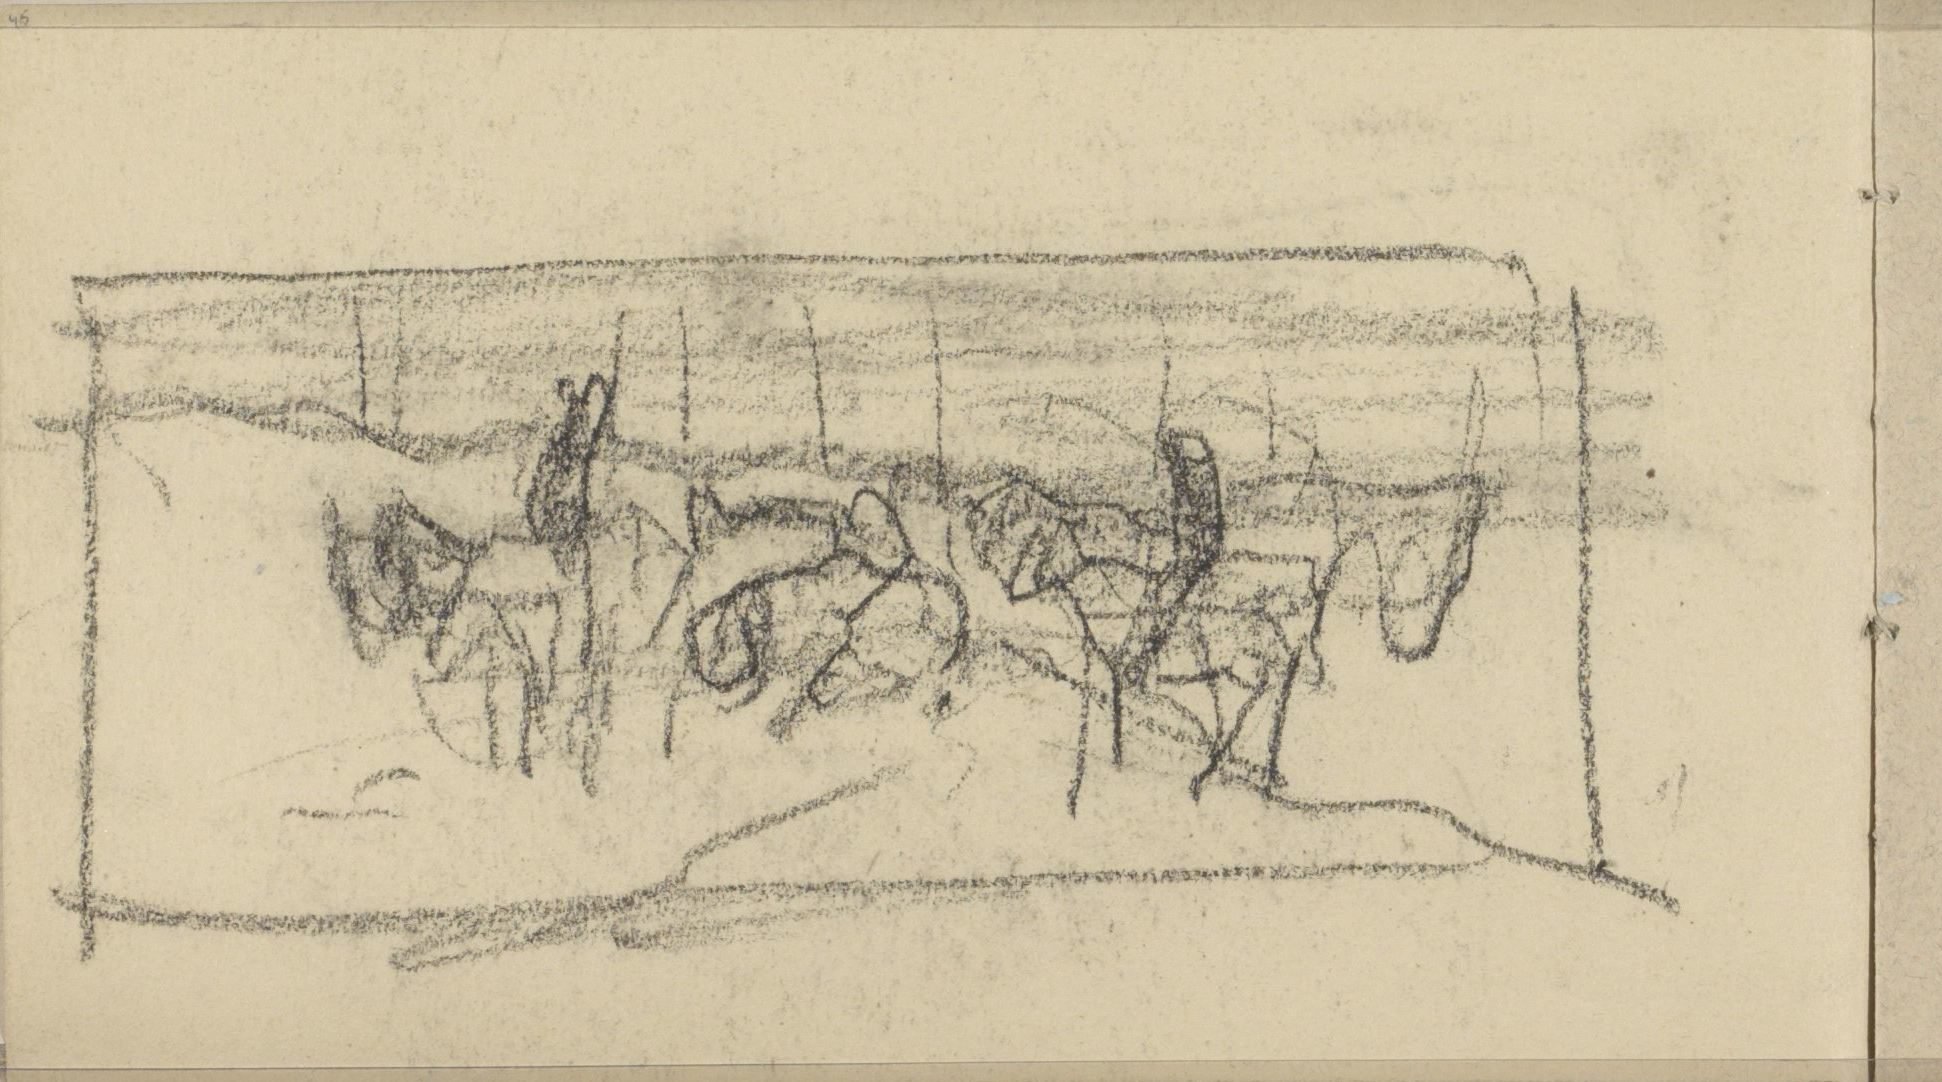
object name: sketchbook leaf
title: Compositiestudie met ruiters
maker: george hendrik breitner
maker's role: draughtsman, painter, print maker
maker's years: 1857-1923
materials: chalk, paper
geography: amsterdam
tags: riding a horse, ass, or mule; rider, horseman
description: Pagina 45 uit een schetsboek met 32 bladen.